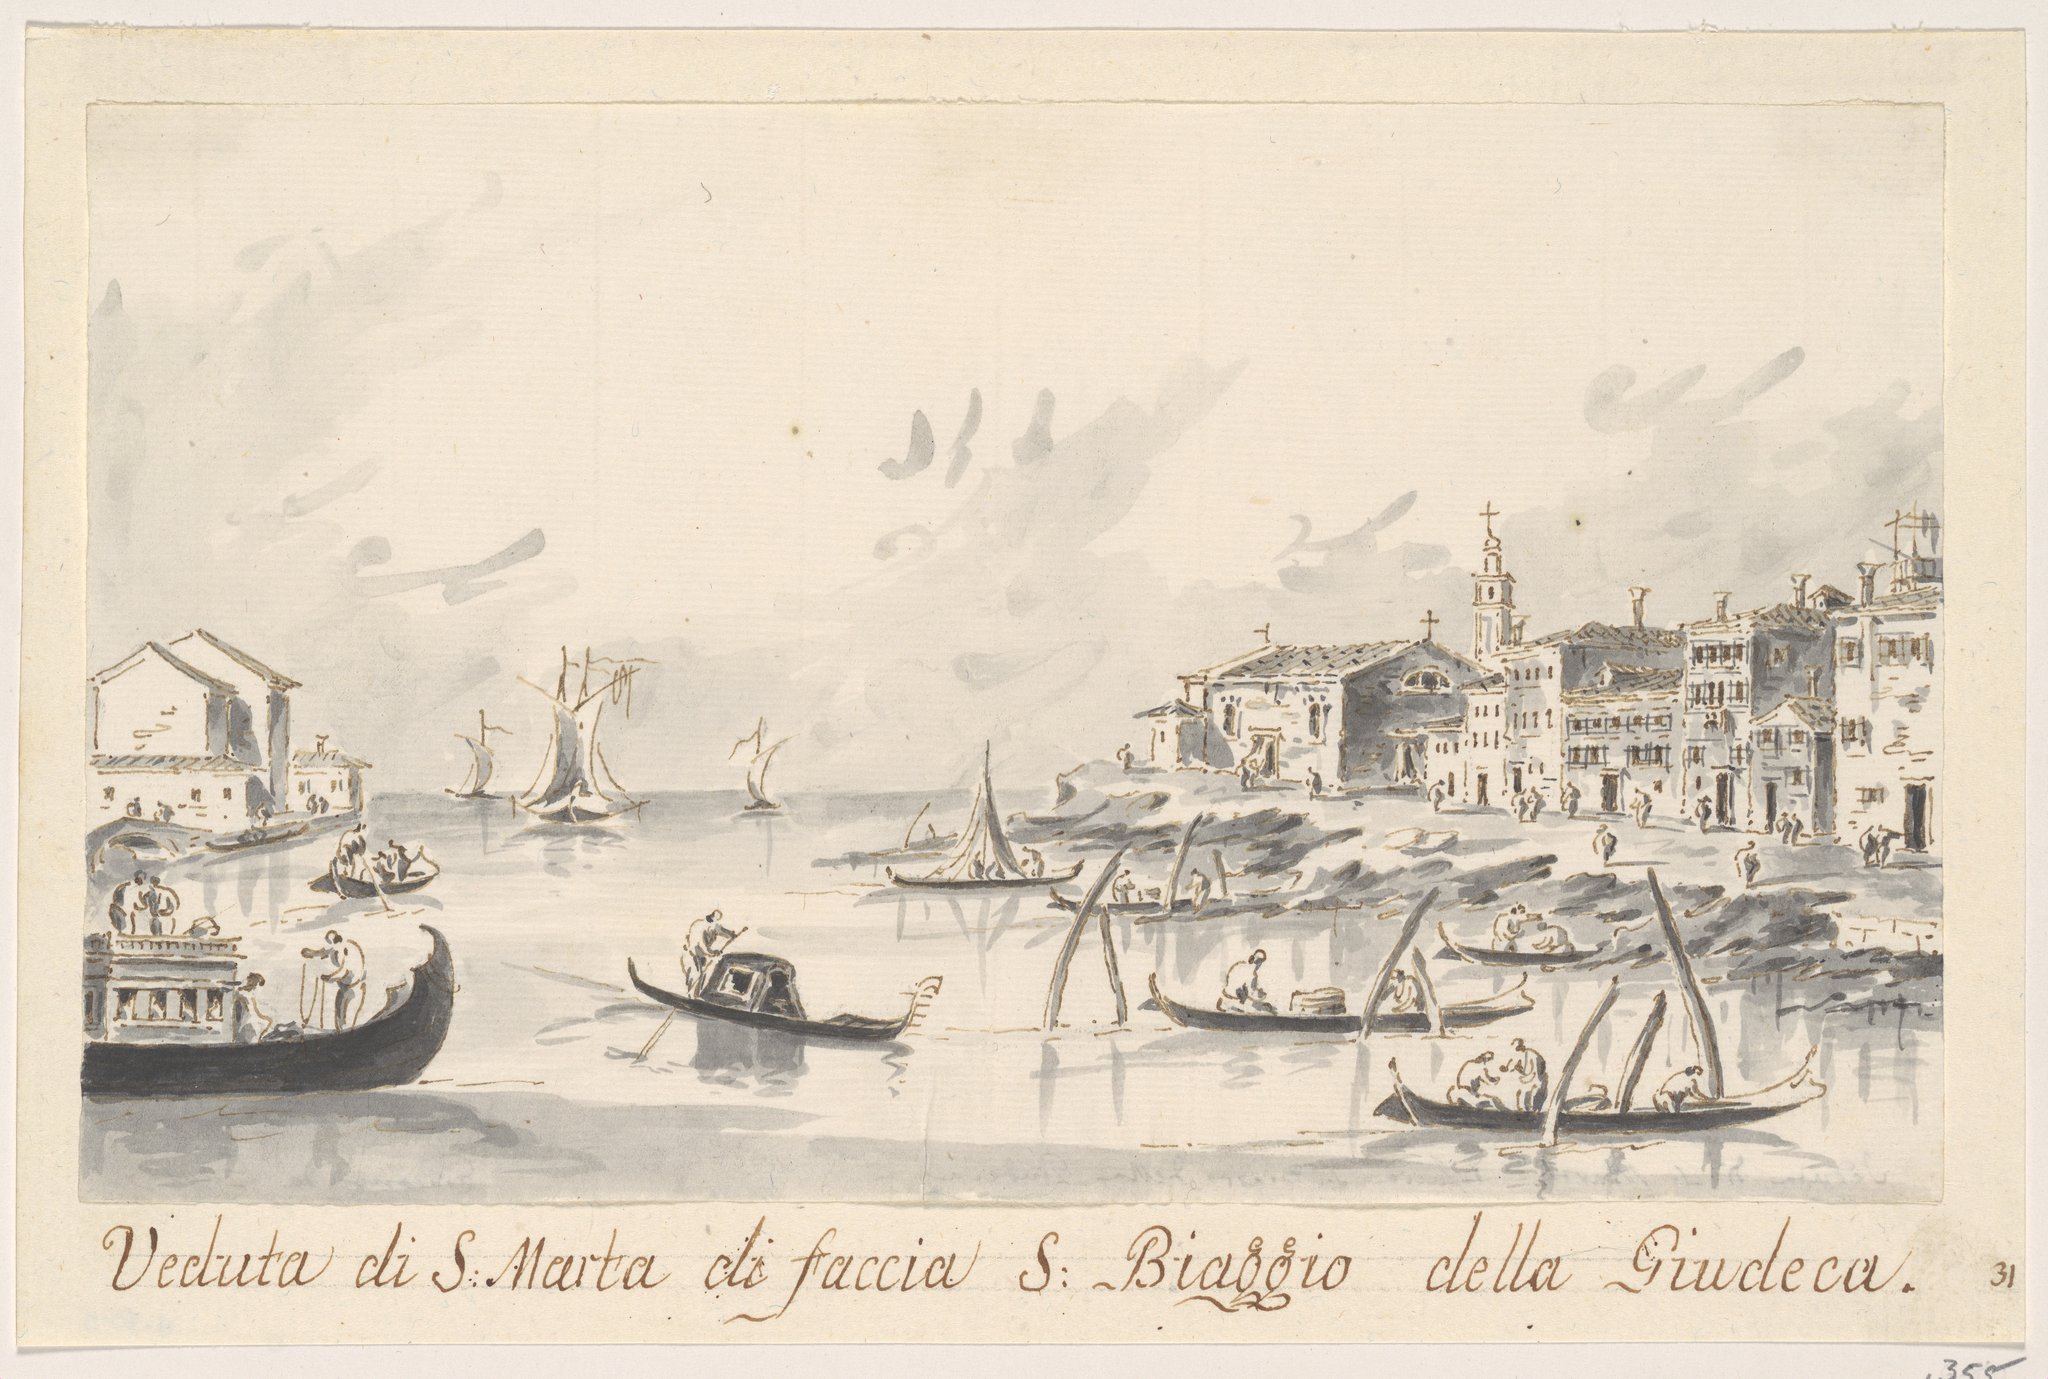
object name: drawing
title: The Punta di Santa Marta, Opposite the Giudecca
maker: giacomo guardi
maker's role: artist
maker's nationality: italian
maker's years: 1764-1835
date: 1804-1828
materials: ink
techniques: pen, wash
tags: canals,boats